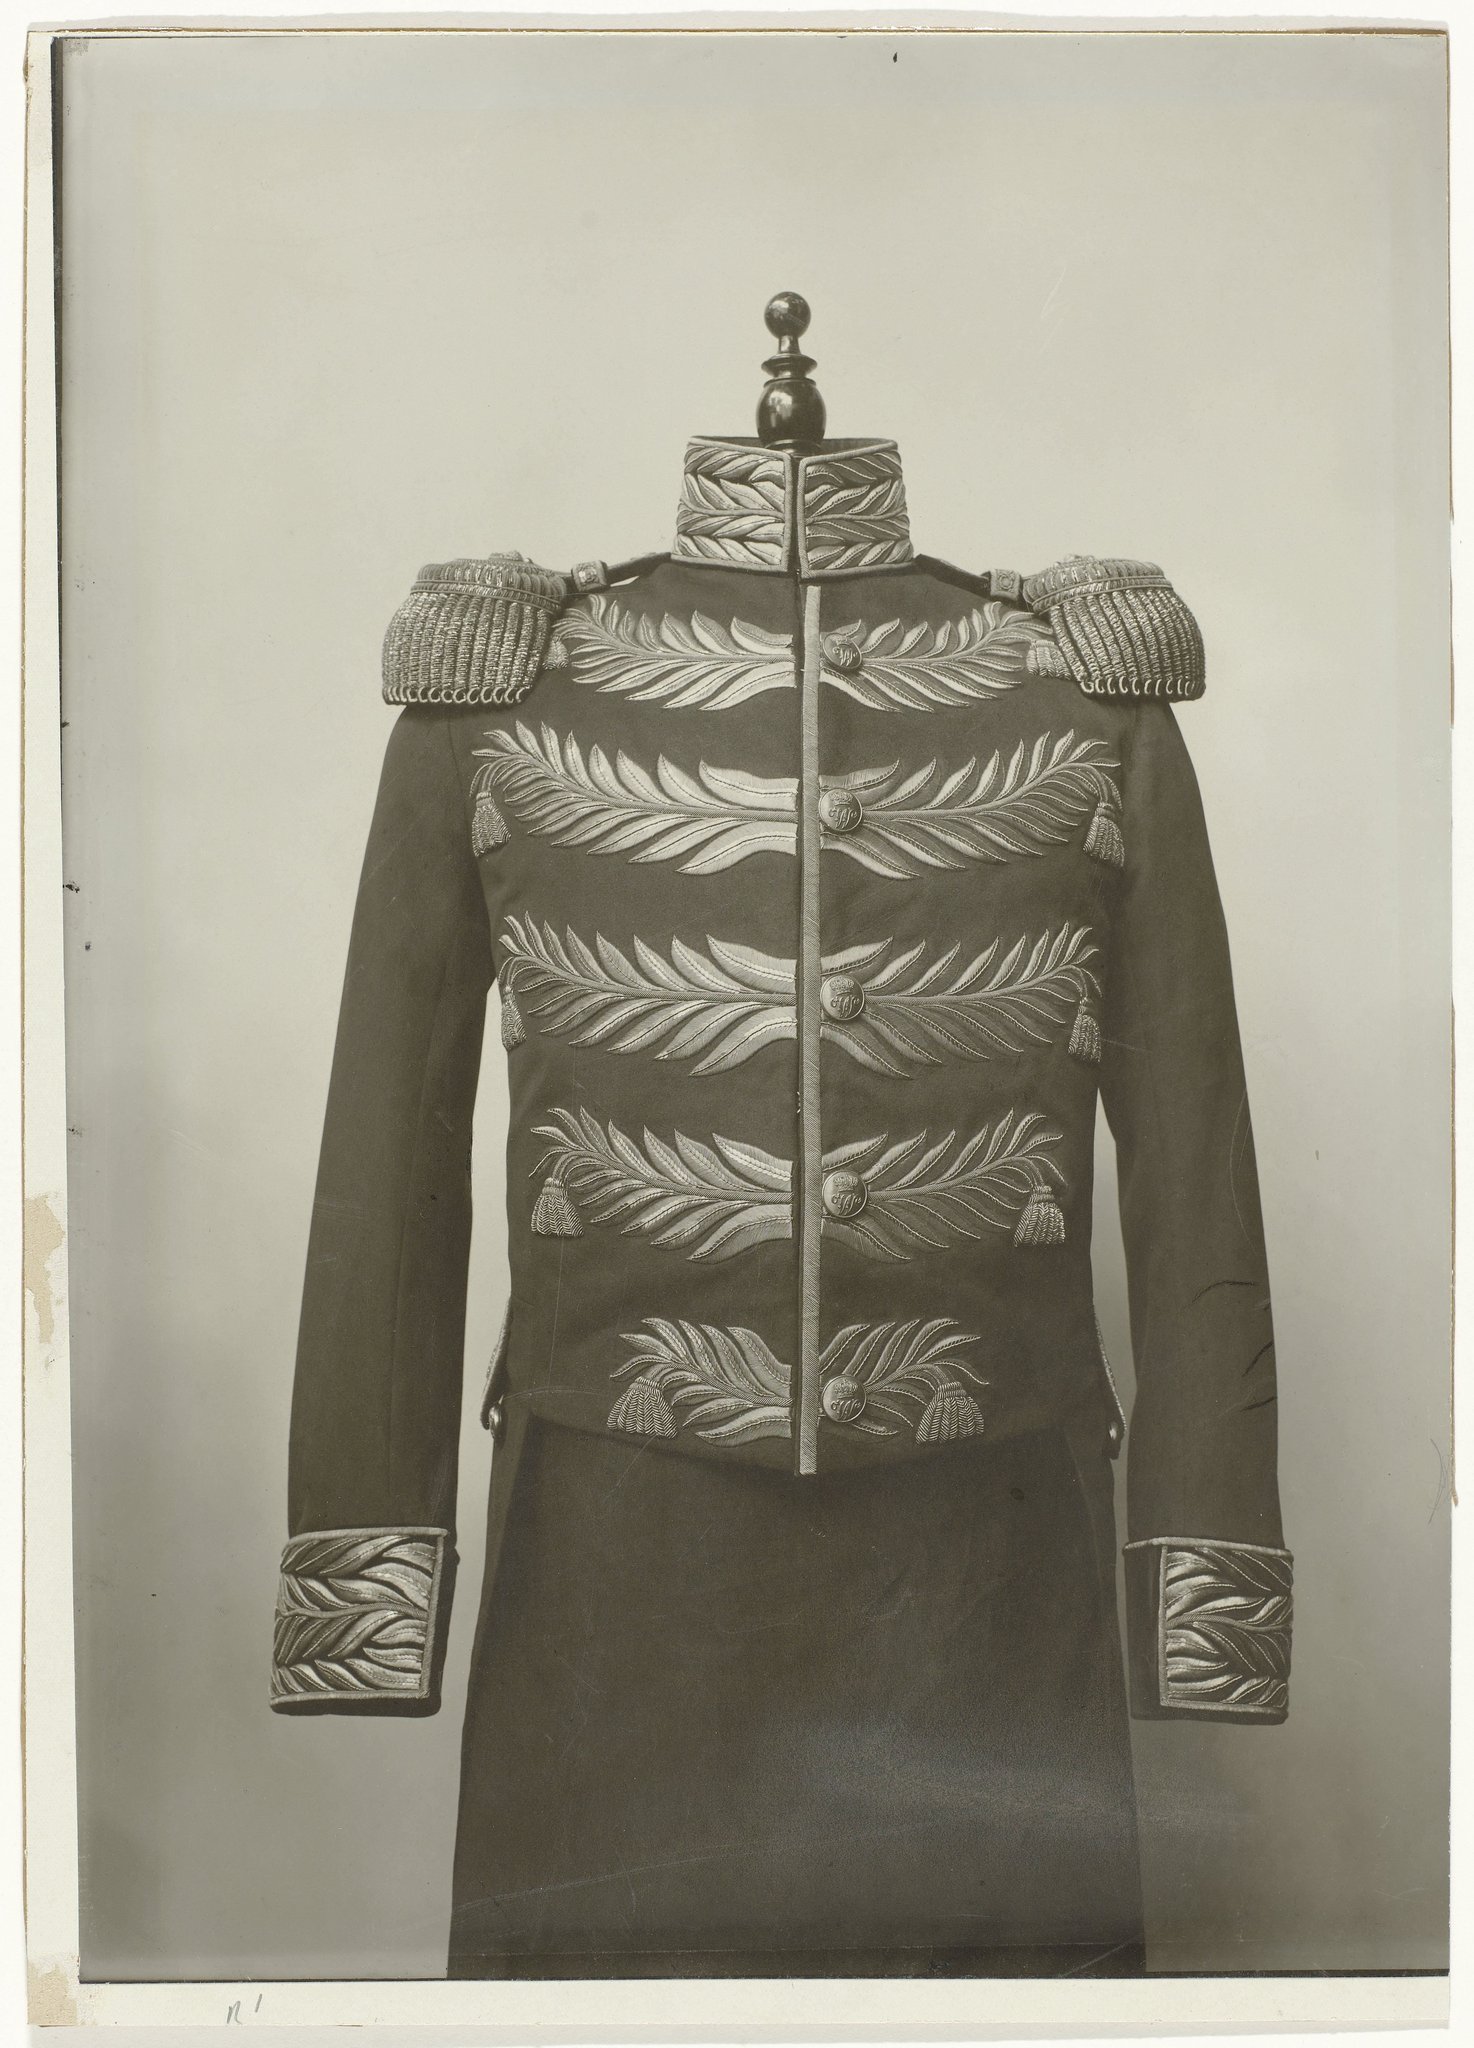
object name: photograph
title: Kamerheer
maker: peter clausing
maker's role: fotograaf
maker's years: 1870-1913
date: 1875-1900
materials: cardboard, paper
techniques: photography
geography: haarlem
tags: netherlands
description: Eén van acht foto's van ambtskostuums, in grijsbruin passe-partout met onder benaming in verf, kapitalen, zwarte letter met witte 'schaduw'. Onderschrift: KAMERHEER. Foto: achterkant. Gemerkt; r.o.: reliëfstempel: 'P. Clausing jr / Haarlem'. Opmerking: zie NG-1029-A t/m H.